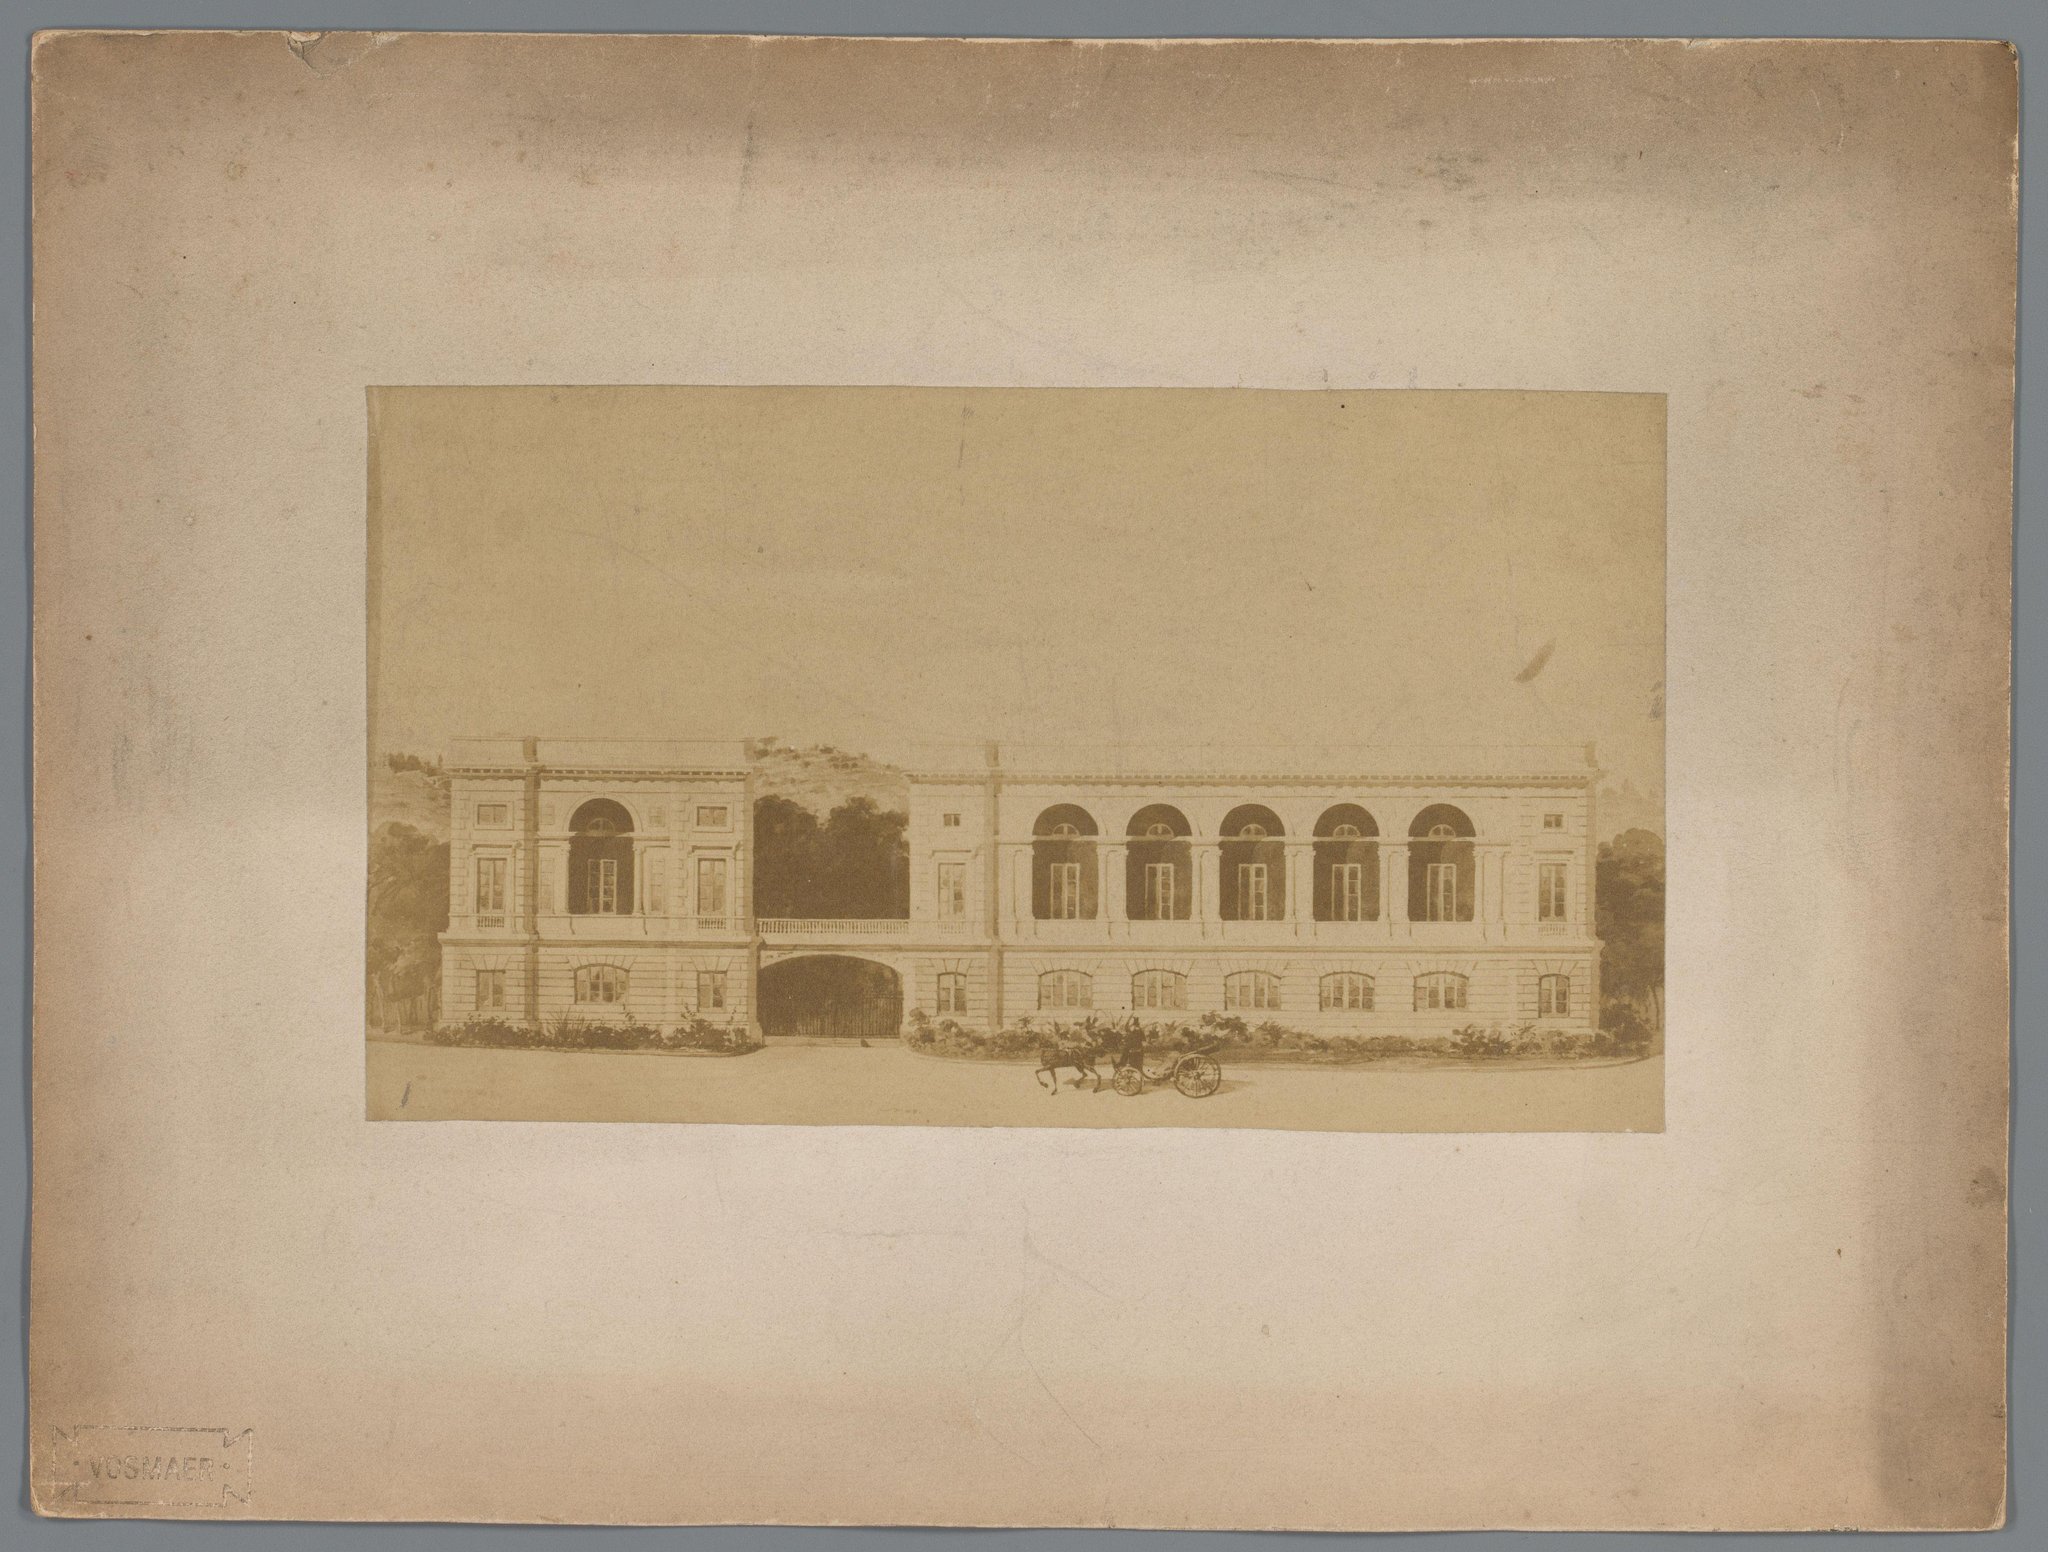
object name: reproduction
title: Fotoreproductie van een schilderij voorstellende het Zoölogisch Station te Napels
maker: Anonymous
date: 1874-1900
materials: paper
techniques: albumen print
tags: aquarium, exterior ~ representation of a building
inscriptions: inscription: ‘Zoologisch Station te Napoli’, collector's mark: ‘VOSMAER’